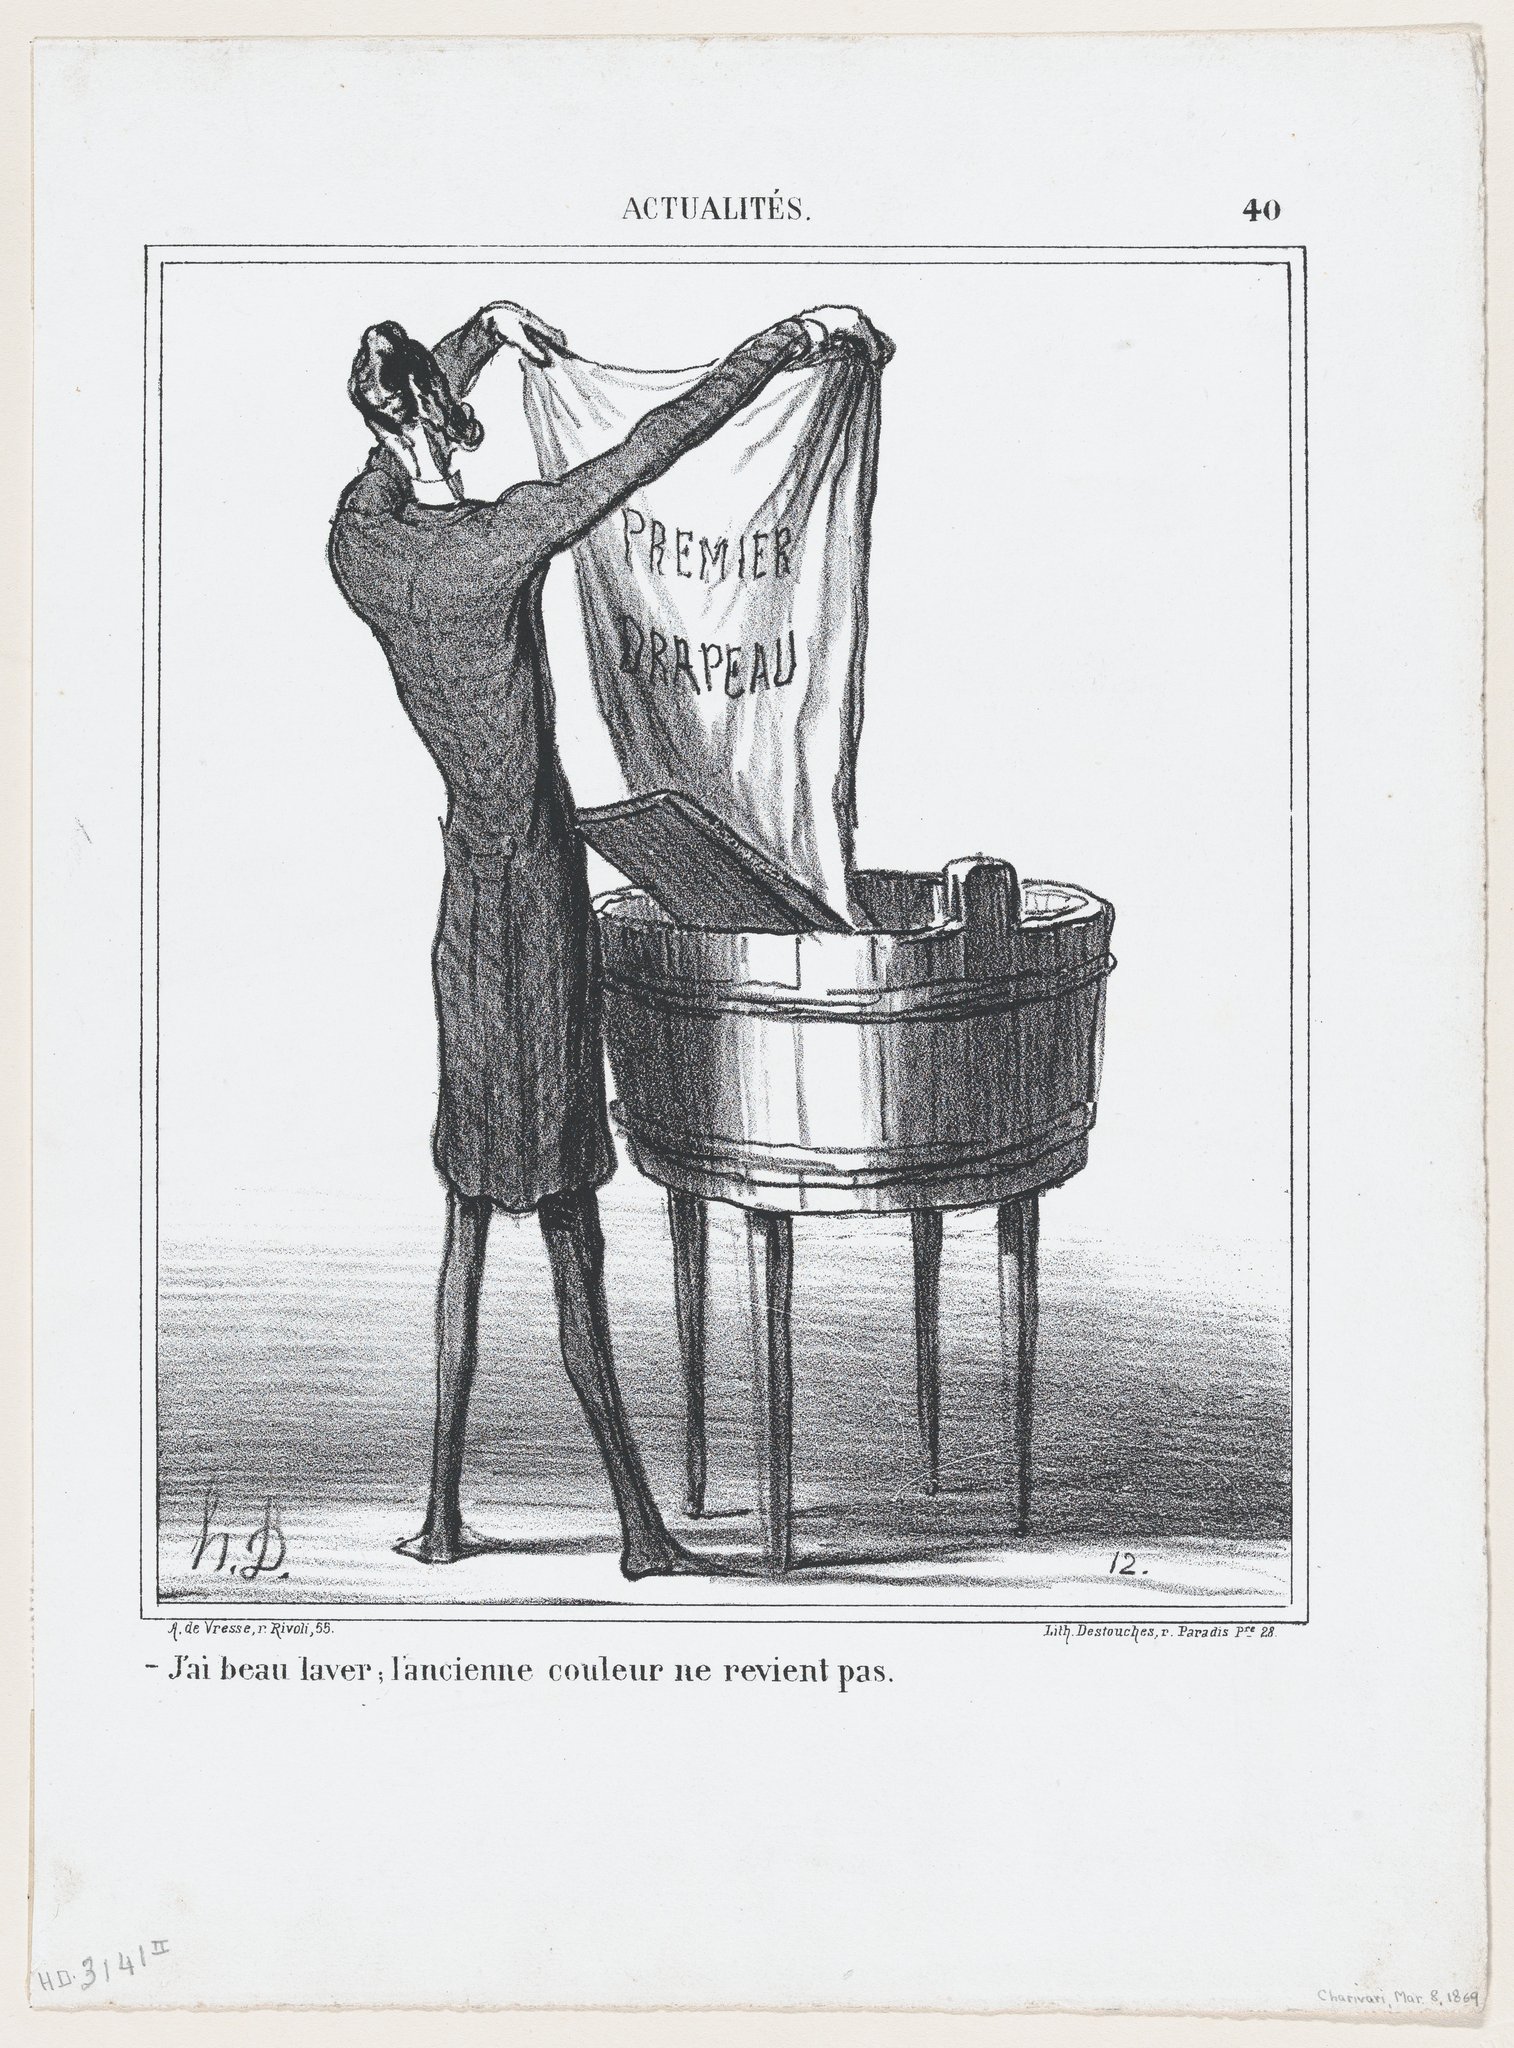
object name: print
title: I can wash as much as I want, the old color won't come back, from 'News of the day,' published in "Le Charivari"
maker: honoré daumier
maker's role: artist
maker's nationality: french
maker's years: 1808-1879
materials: paper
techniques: lithograph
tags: satire,men